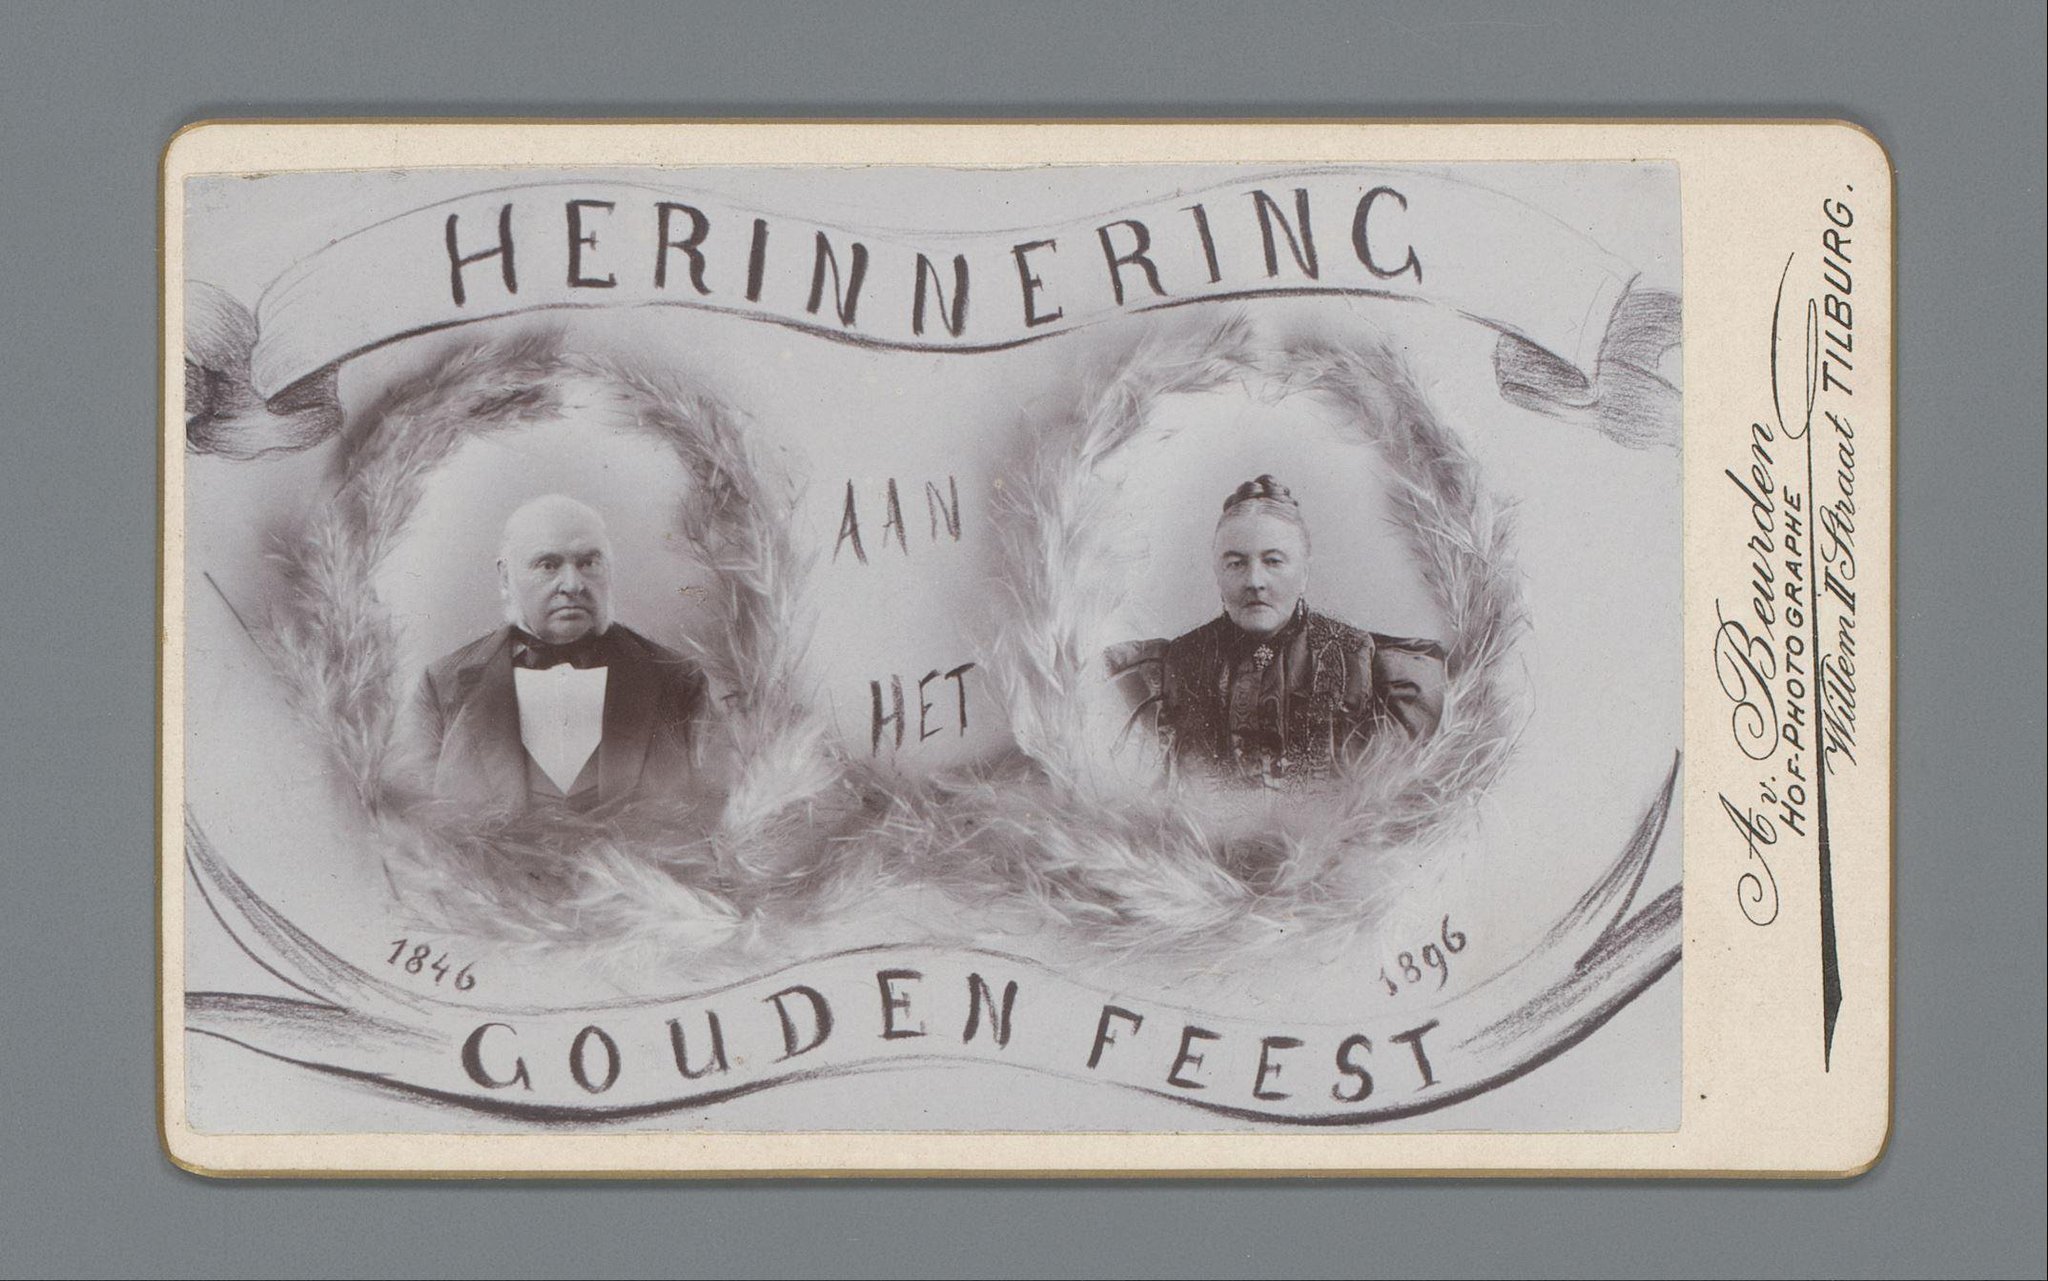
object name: carte de visite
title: Dubbelportret van een onbekende man en vrouw ter herinnering aan hun gouden jubileum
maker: adrianus van beurden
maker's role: fotograaf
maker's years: 1843-1915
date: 1896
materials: paper, cardboard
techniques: gelatin silver print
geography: tilburg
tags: adult woman, adult man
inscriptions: inscription: ‘Specialiteit in Vergrootingen./ G. JANSSEN & Co CÖLN A/RH.’, inscription: ‘HERINNERING/ AAN/ HET/ GOUDEN FEEST/ 1846/ 1896’, address: ‘Tilburg/ Willem II Straat.’